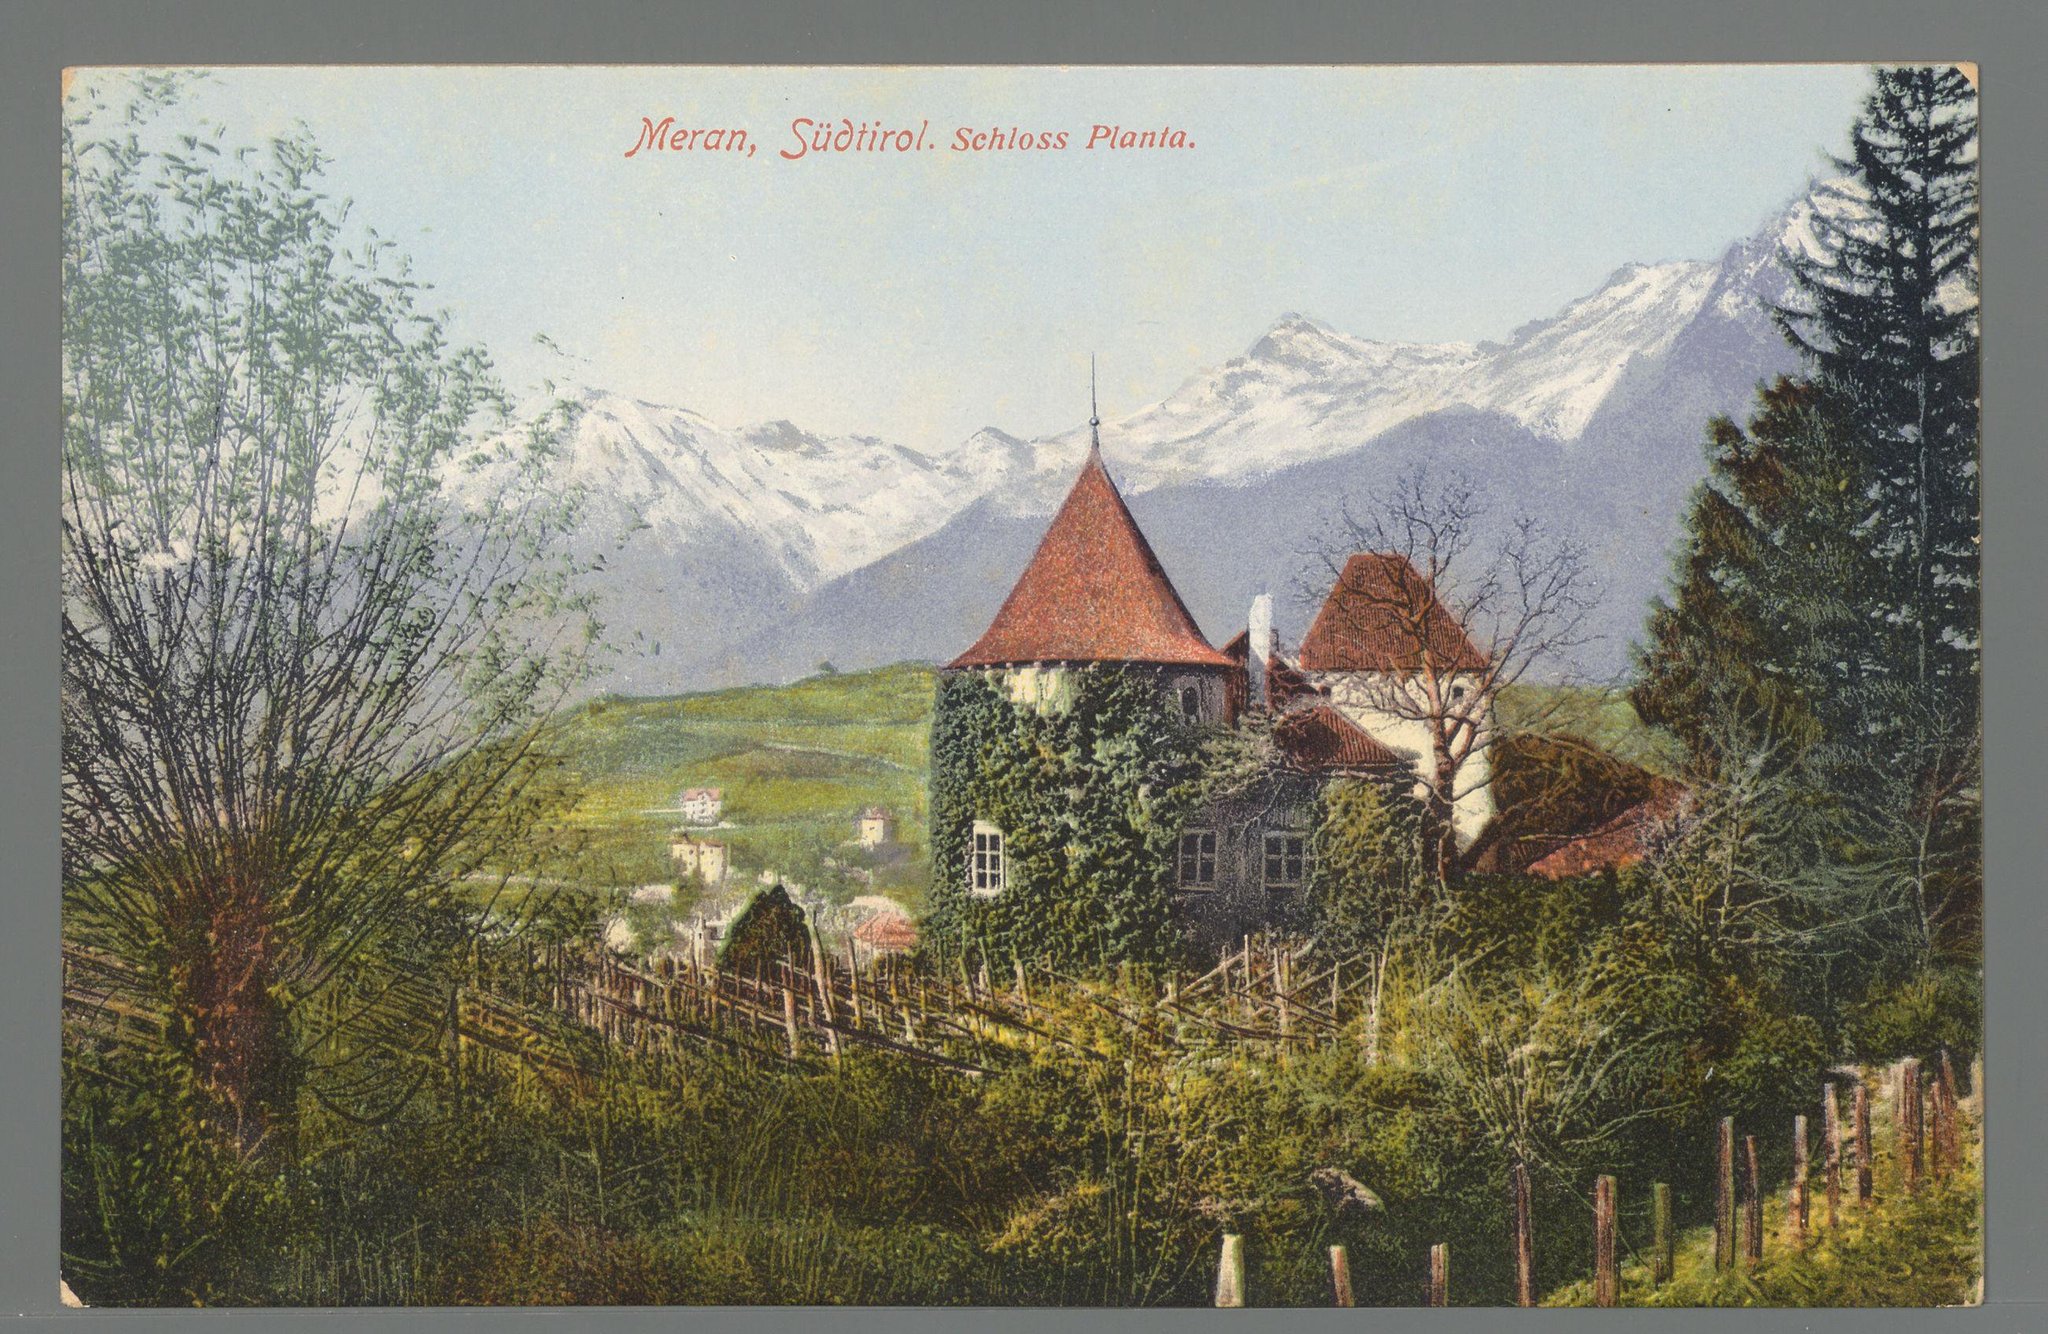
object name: photomechanical print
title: Meran, Südtirol. Schloss Planta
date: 1909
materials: cardboard, photographic process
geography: merano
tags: landscape with tower or castle, mountains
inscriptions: date